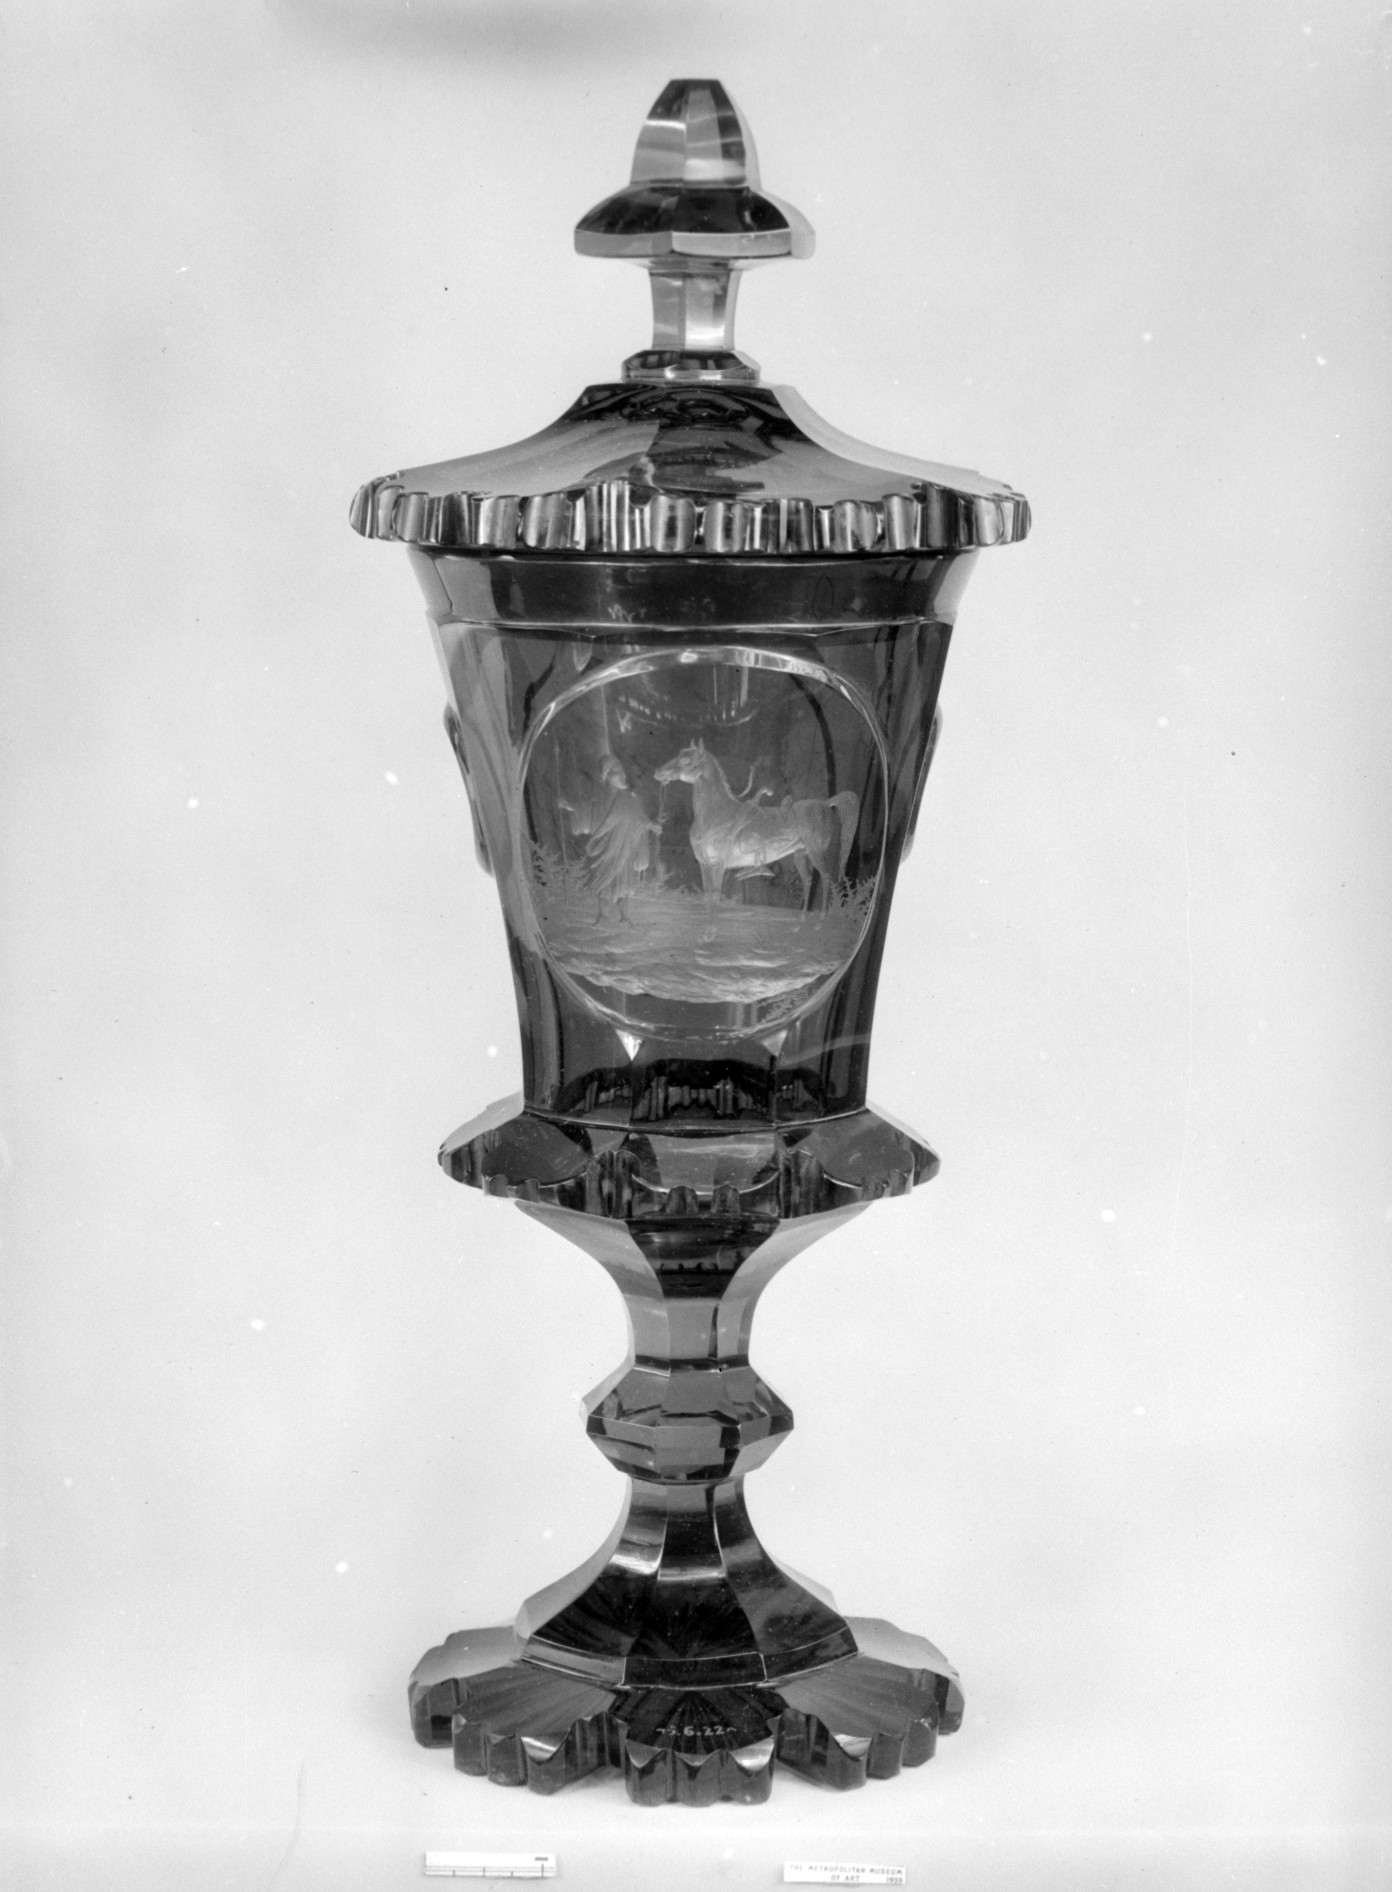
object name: goblet with cover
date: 1850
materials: glass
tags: men,horses